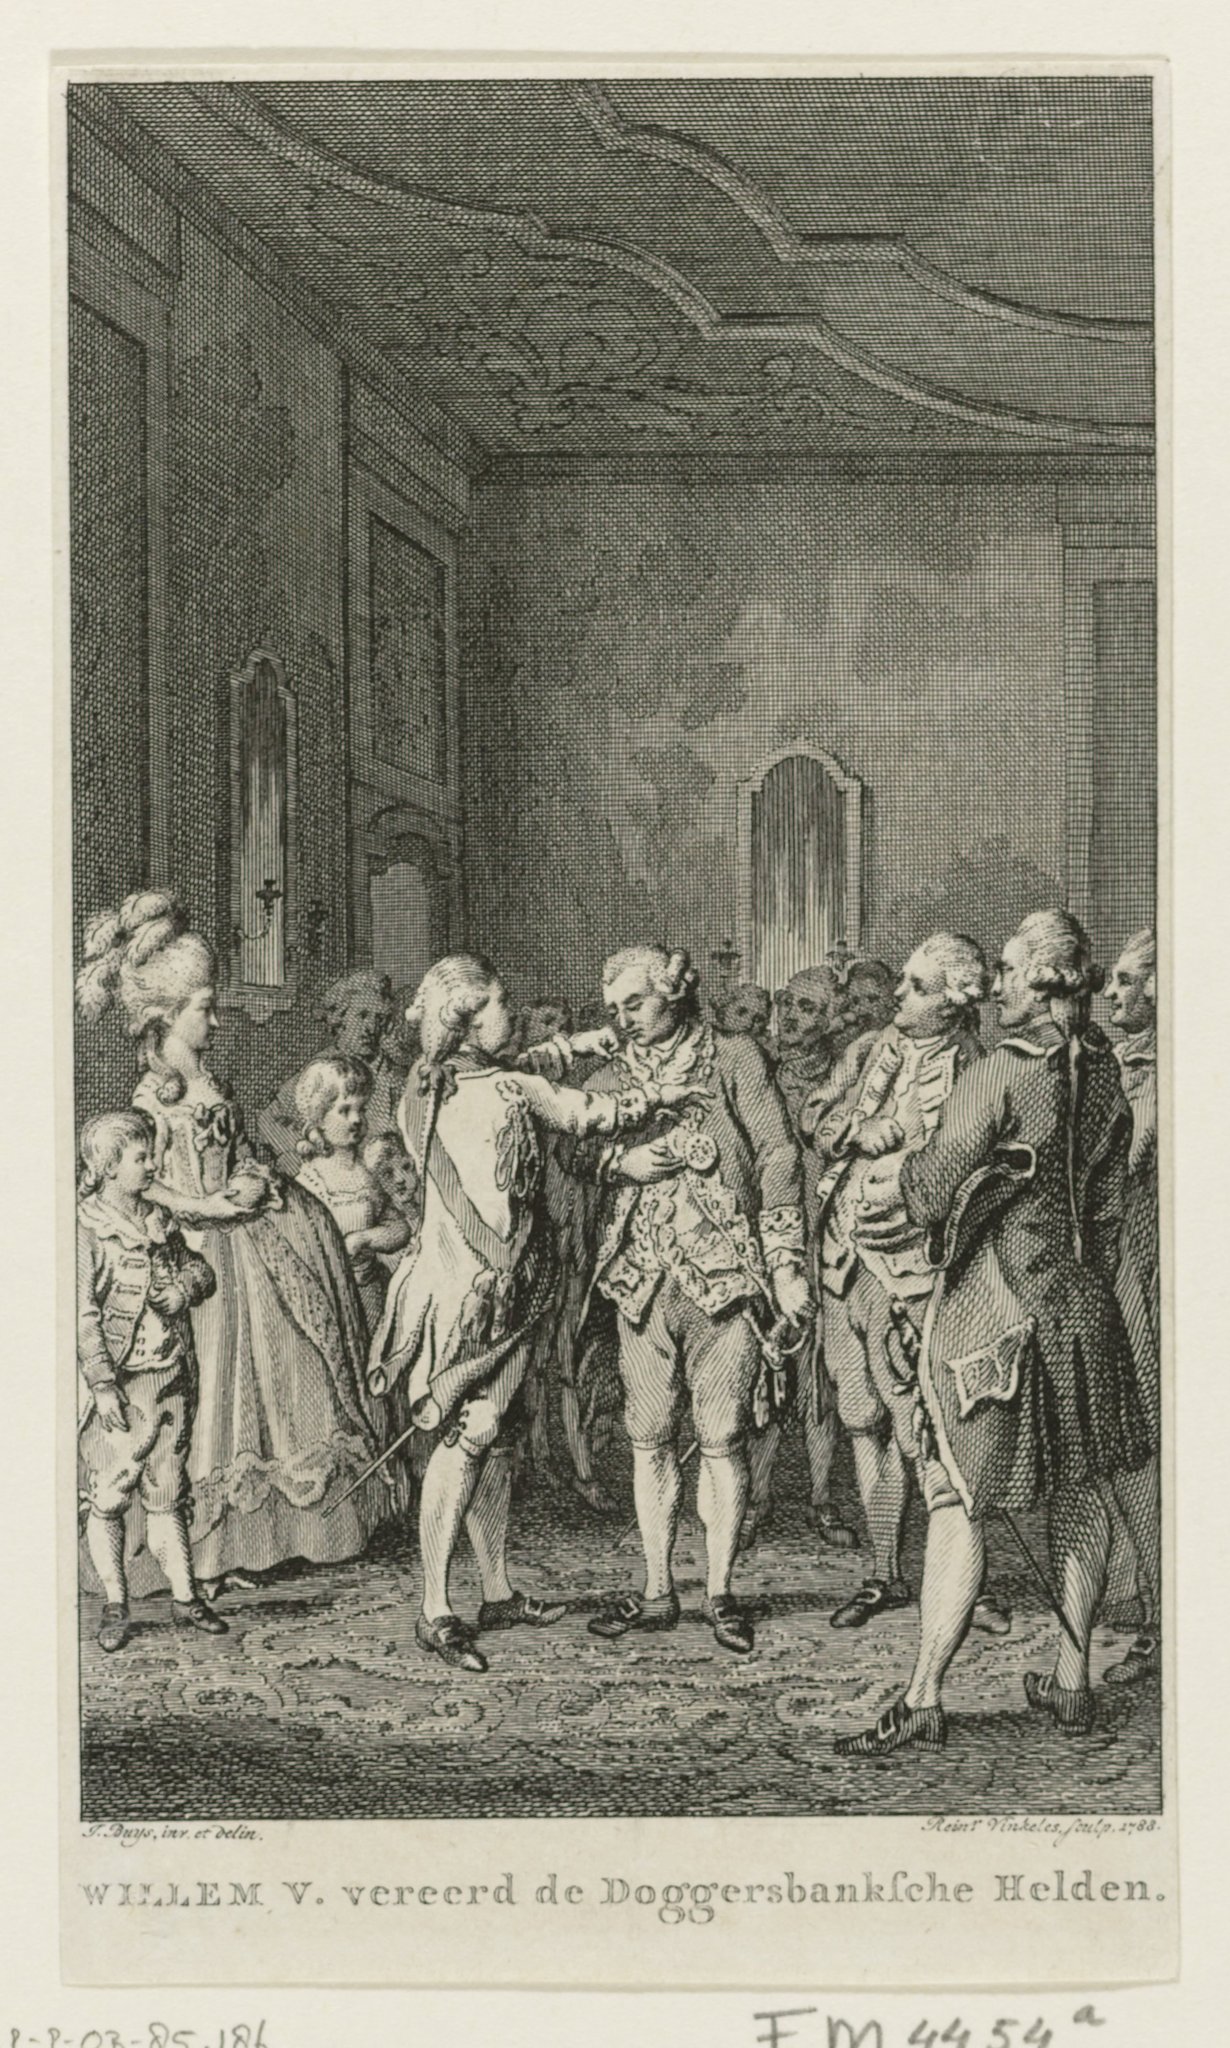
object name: print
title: Willem V. vereerd de Doggerbanksche Helden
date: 1788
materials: paper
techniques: engraving, etching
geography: northern netherlands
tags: the hague, william v (prince of orange), johan arnold zoutman, medals and other marks of military honour (+ sailing-ships)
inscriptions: collector's mark: Lugt 2228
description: Gebruikt als illustratie in: P.A. Loosjes. Vaderlandsche historie, vervattende de geschiedenissen, der Vereenigde Nederlanden (...). Ten onmiddelyken vervolge van Wagenaar's Vaderlandsche historie. Dl. 3. Amsterdam: J. Allart, 1788.